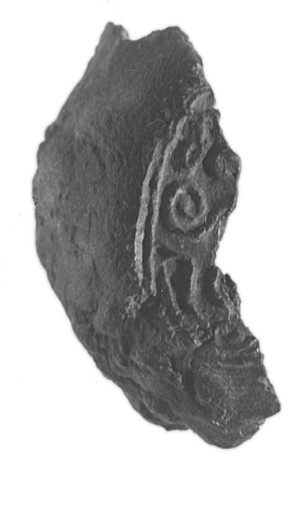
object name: sealing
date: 2030-1640 BCE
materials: clay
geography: egypt